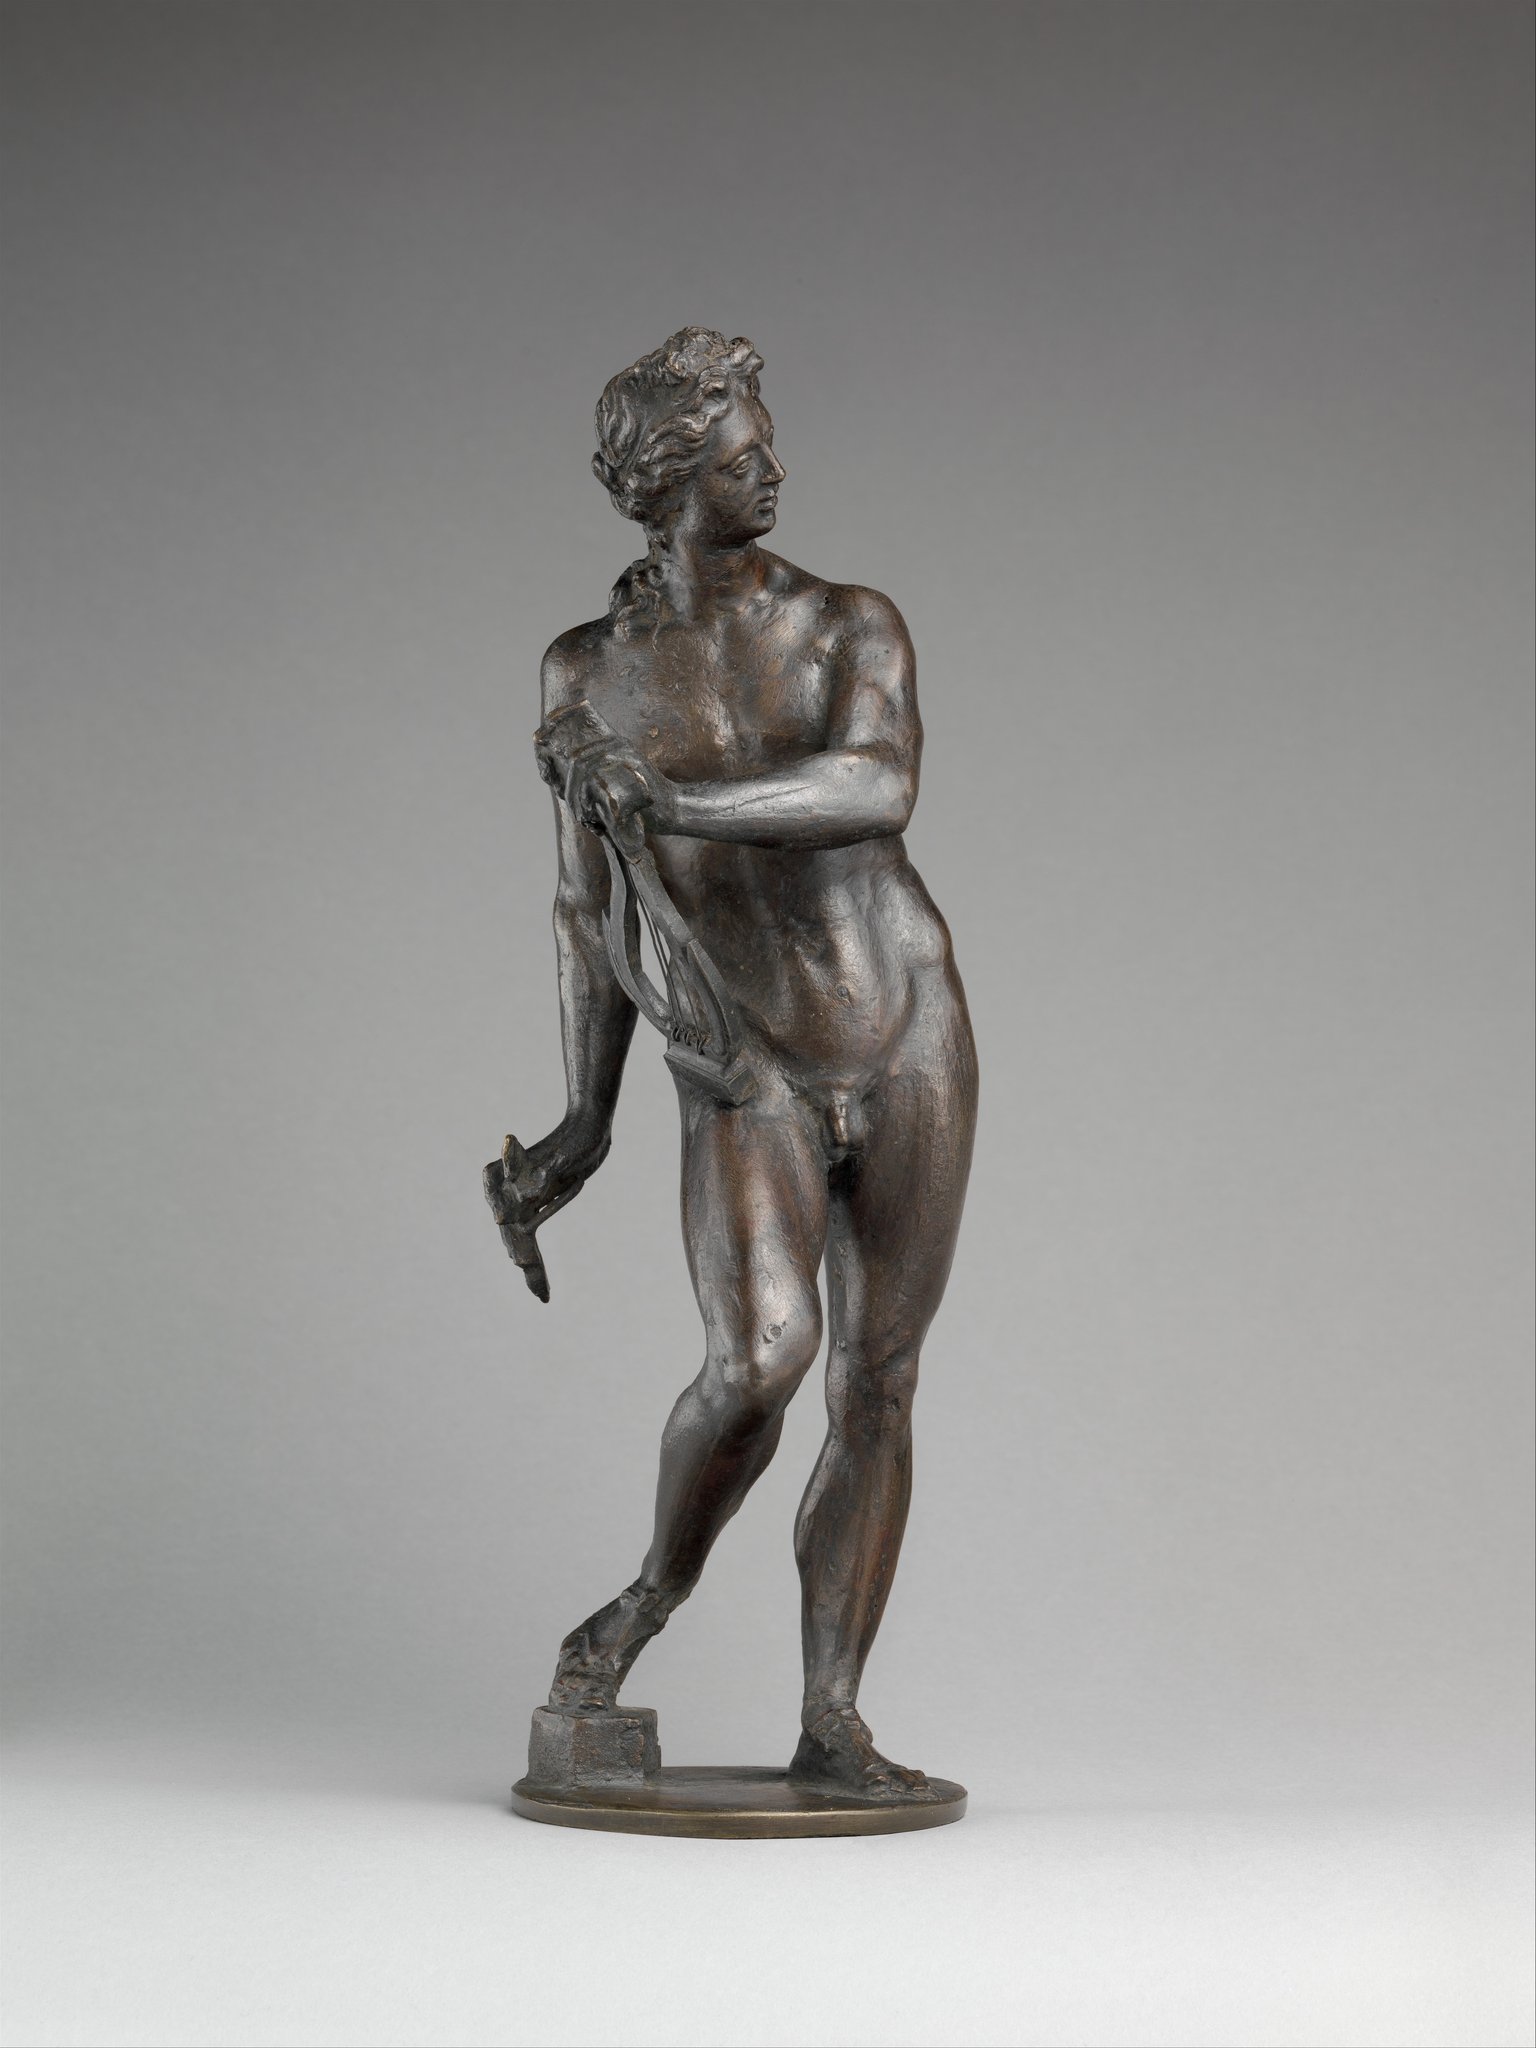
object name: statuette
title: Apollo with lyre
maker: tiziano aspetti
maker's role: artist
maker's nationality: italian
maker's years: 1565-1607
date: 1601-1700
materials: bronze, iron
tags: musical instruments,apollo